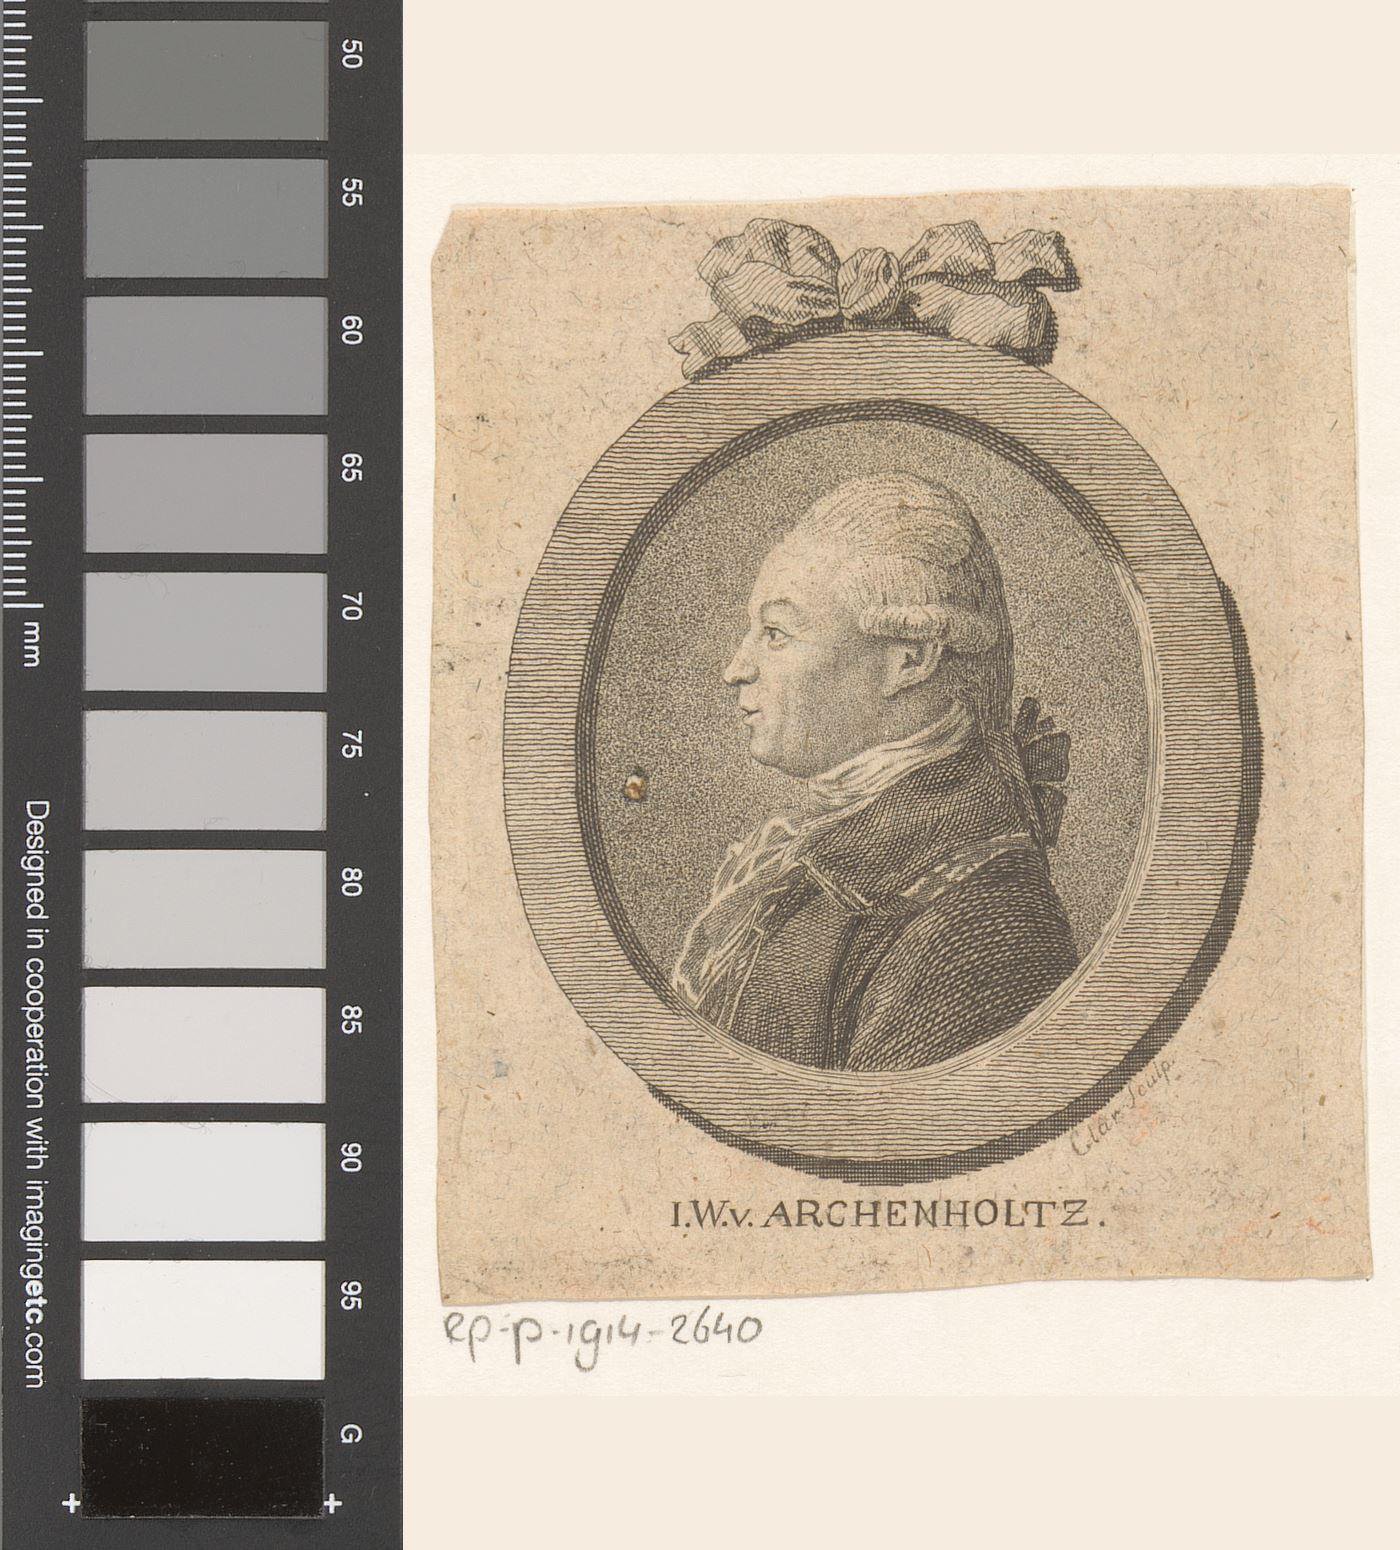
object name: print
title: Portret van Johann Wilhelm von Archenholz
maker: johann friedrich august clar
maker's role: print maker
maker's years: 1768-1844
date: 1778-1844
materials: paper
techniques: engraving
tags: ornament ~ medallion, historical persons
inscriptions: collector's mark: Lugt 2228